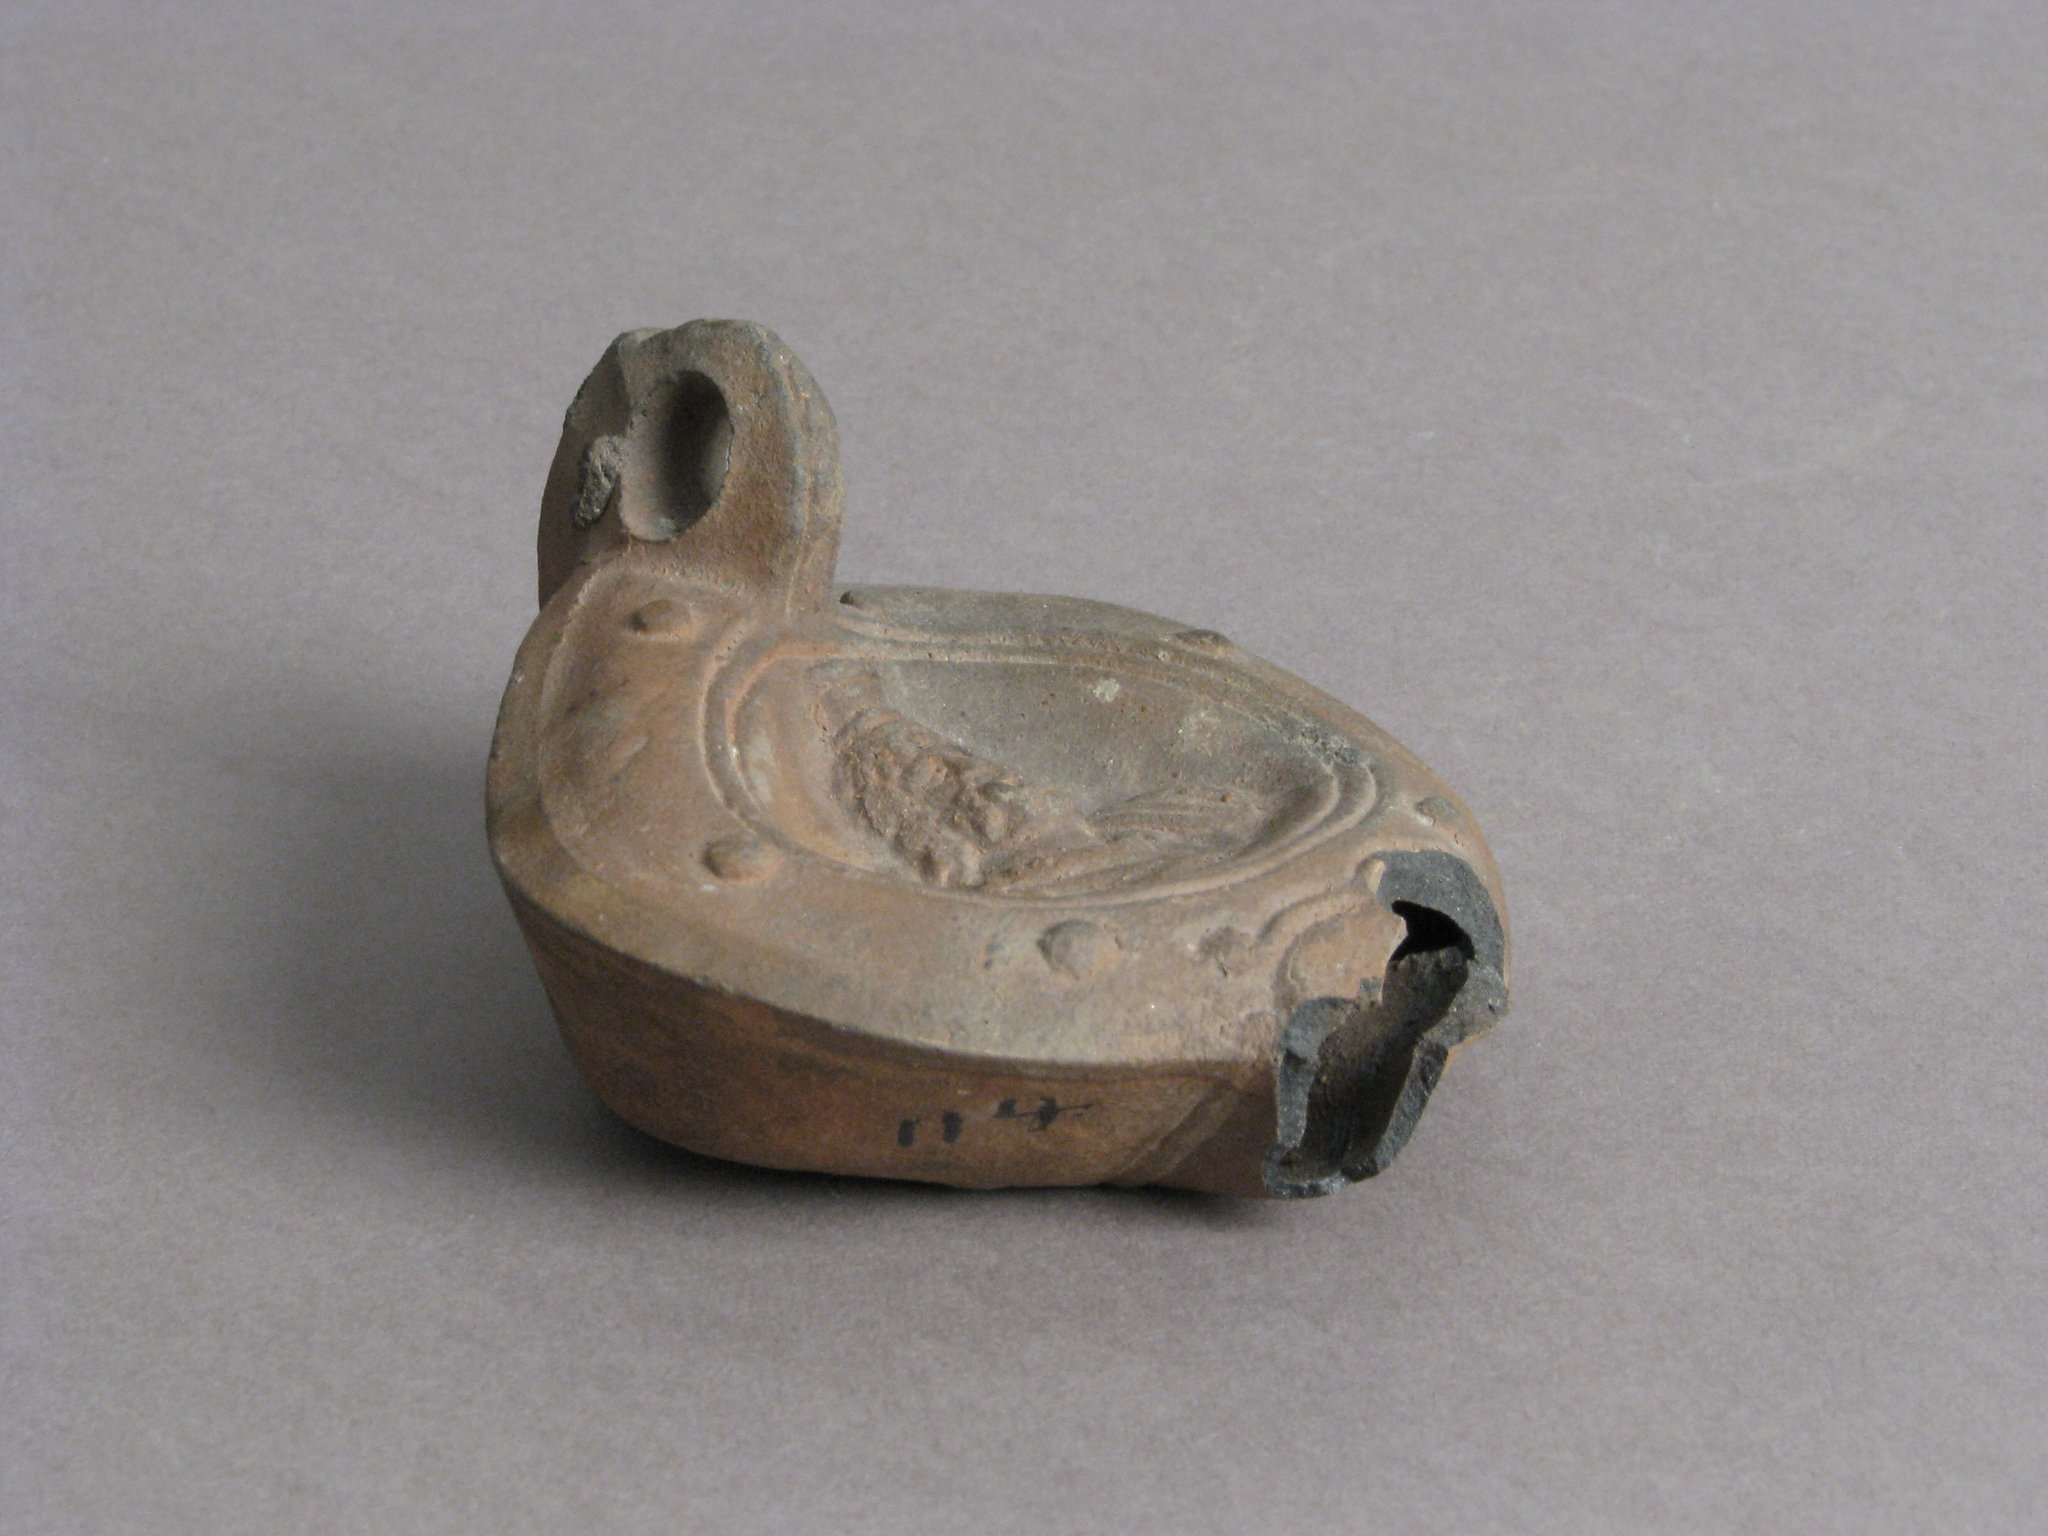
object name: lamp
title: Oil Lamp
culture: coptic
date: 301-700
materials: earthenware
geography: egypt